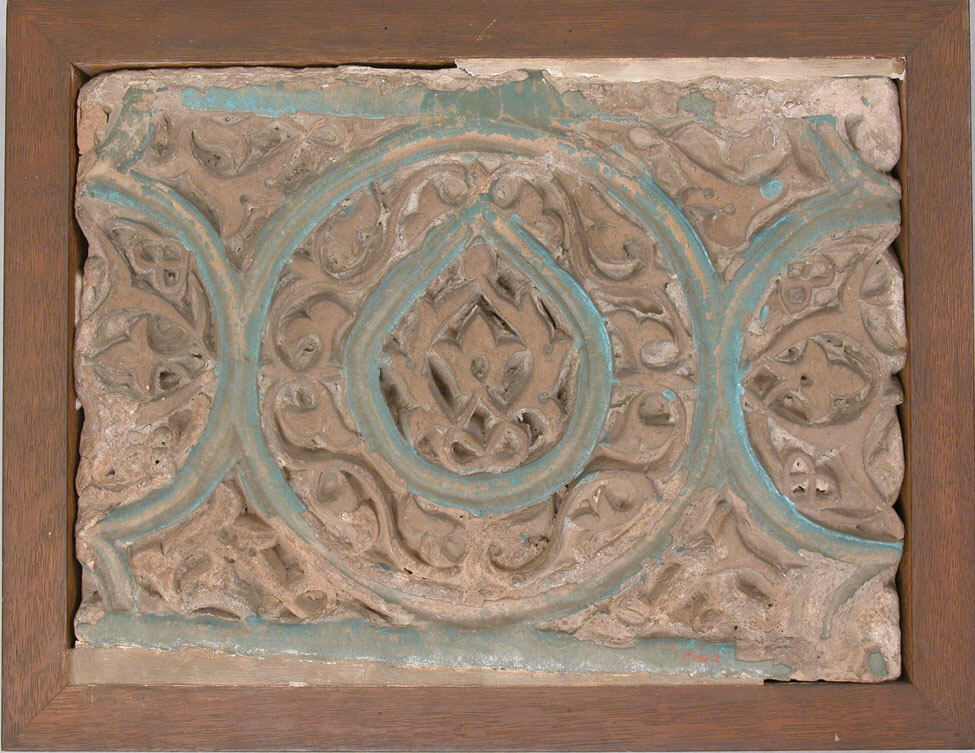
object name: tile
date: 1301-1500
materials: stonepaste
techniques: carving, glazing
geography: central asia